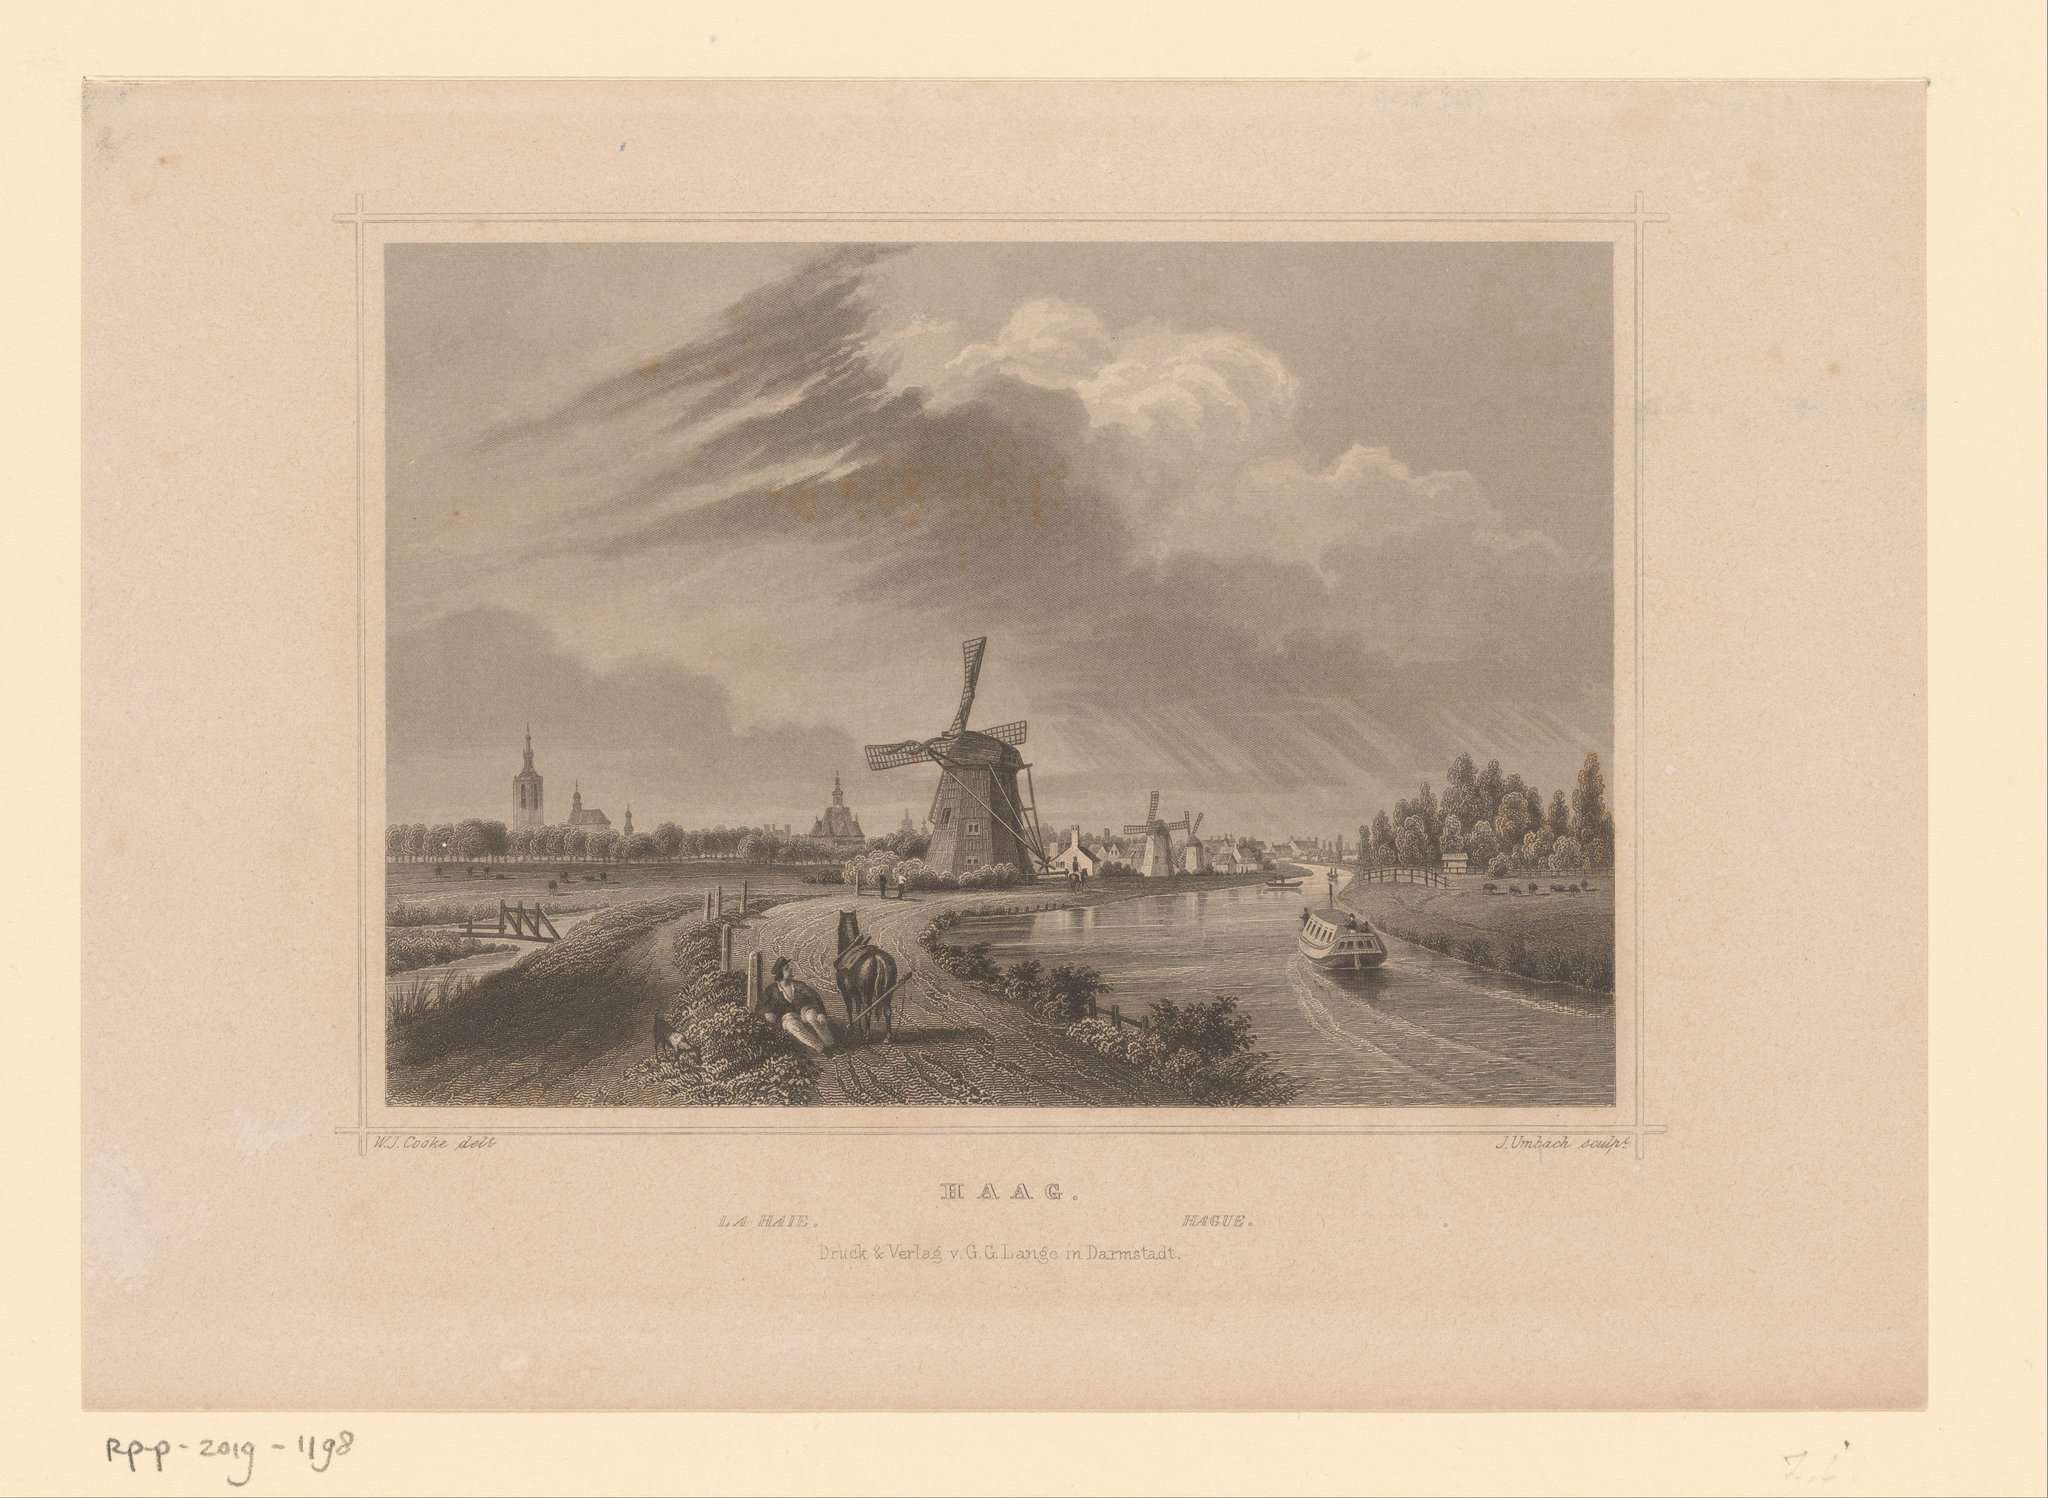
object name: print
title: Haag / La Haie / Hague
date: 1822-1873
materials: paper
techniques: lithograph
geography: darmstadt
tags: city-view, and landscape with man-made constructions, windmill in landscape, the hague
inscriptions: collector's mark: Lugt 2233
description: Prent ook verschenen in: Terwen, Johannes Leonardus. Het Koningrijk der Nederlanden voorgesteld in eene reeks van naar de natuur geteekende schilderachtige gezigten. Gouda: Van Goor, 1858-1862.